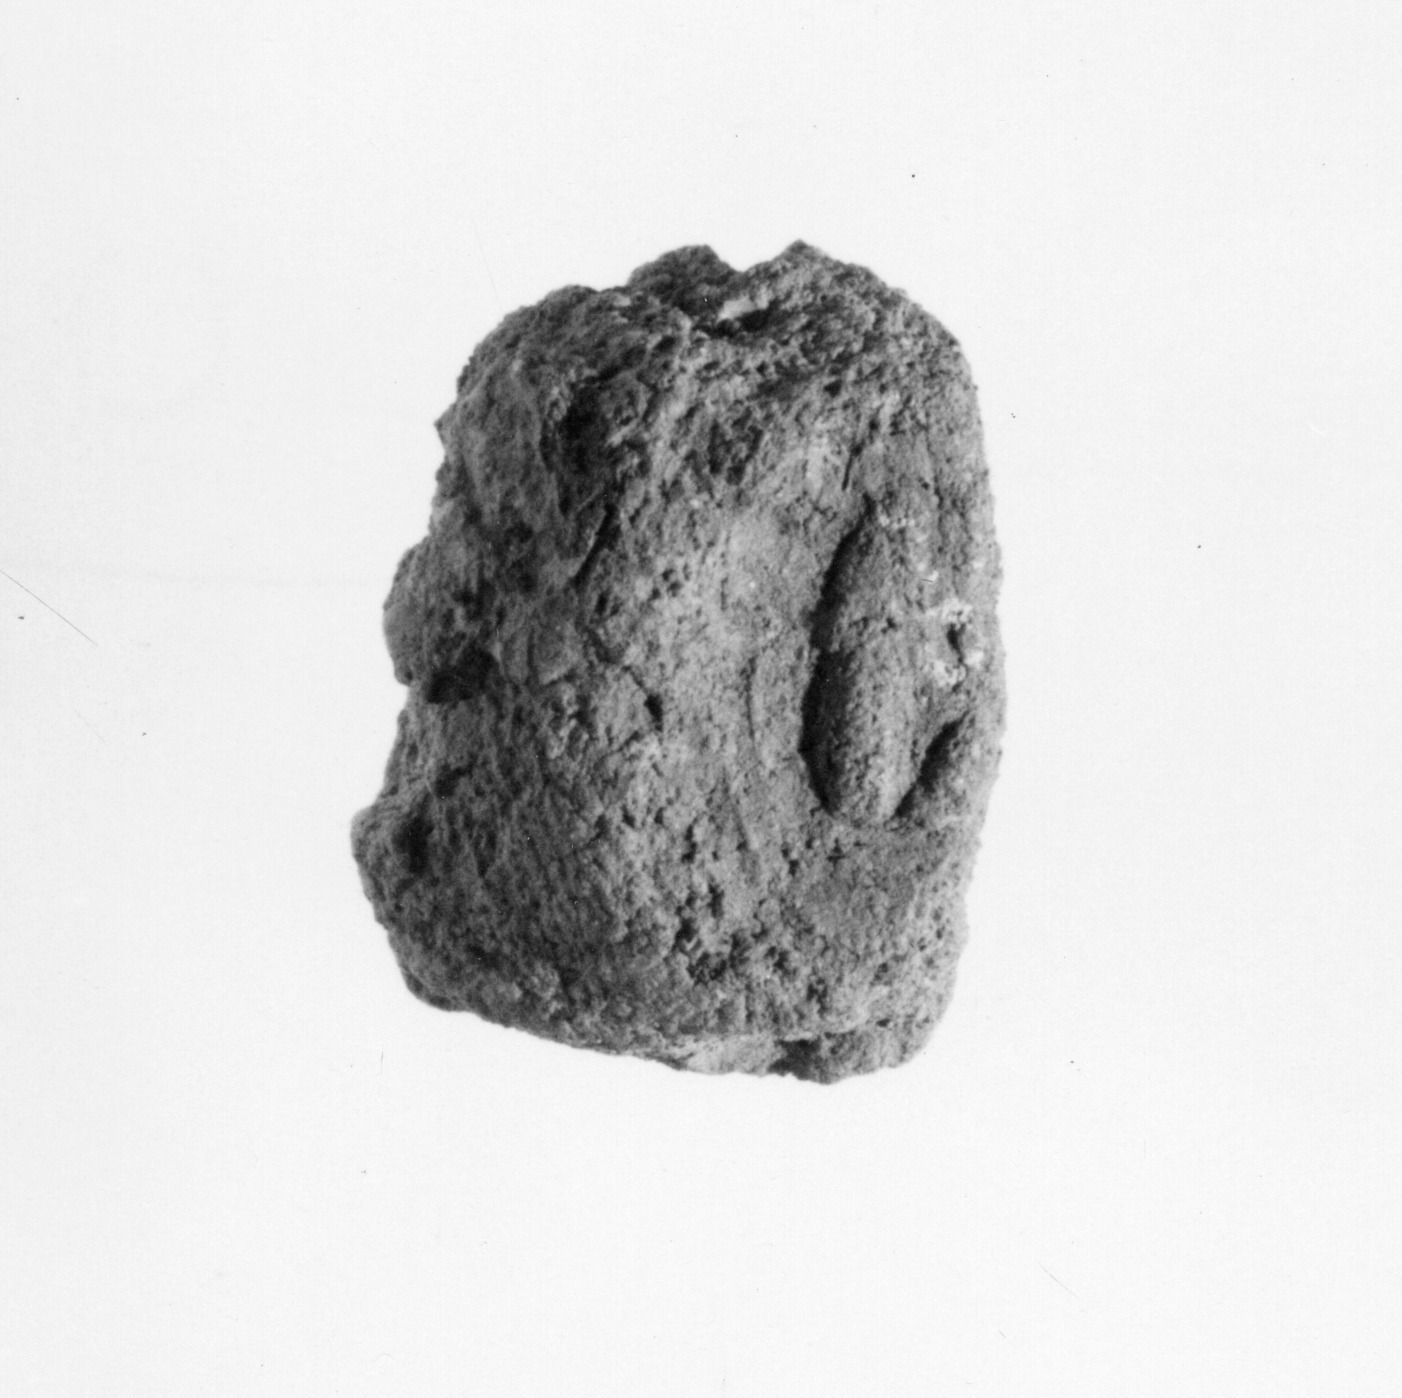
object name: sealing, no type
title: Document Sealing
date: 1390-1352 BCE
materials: mud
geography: egypt